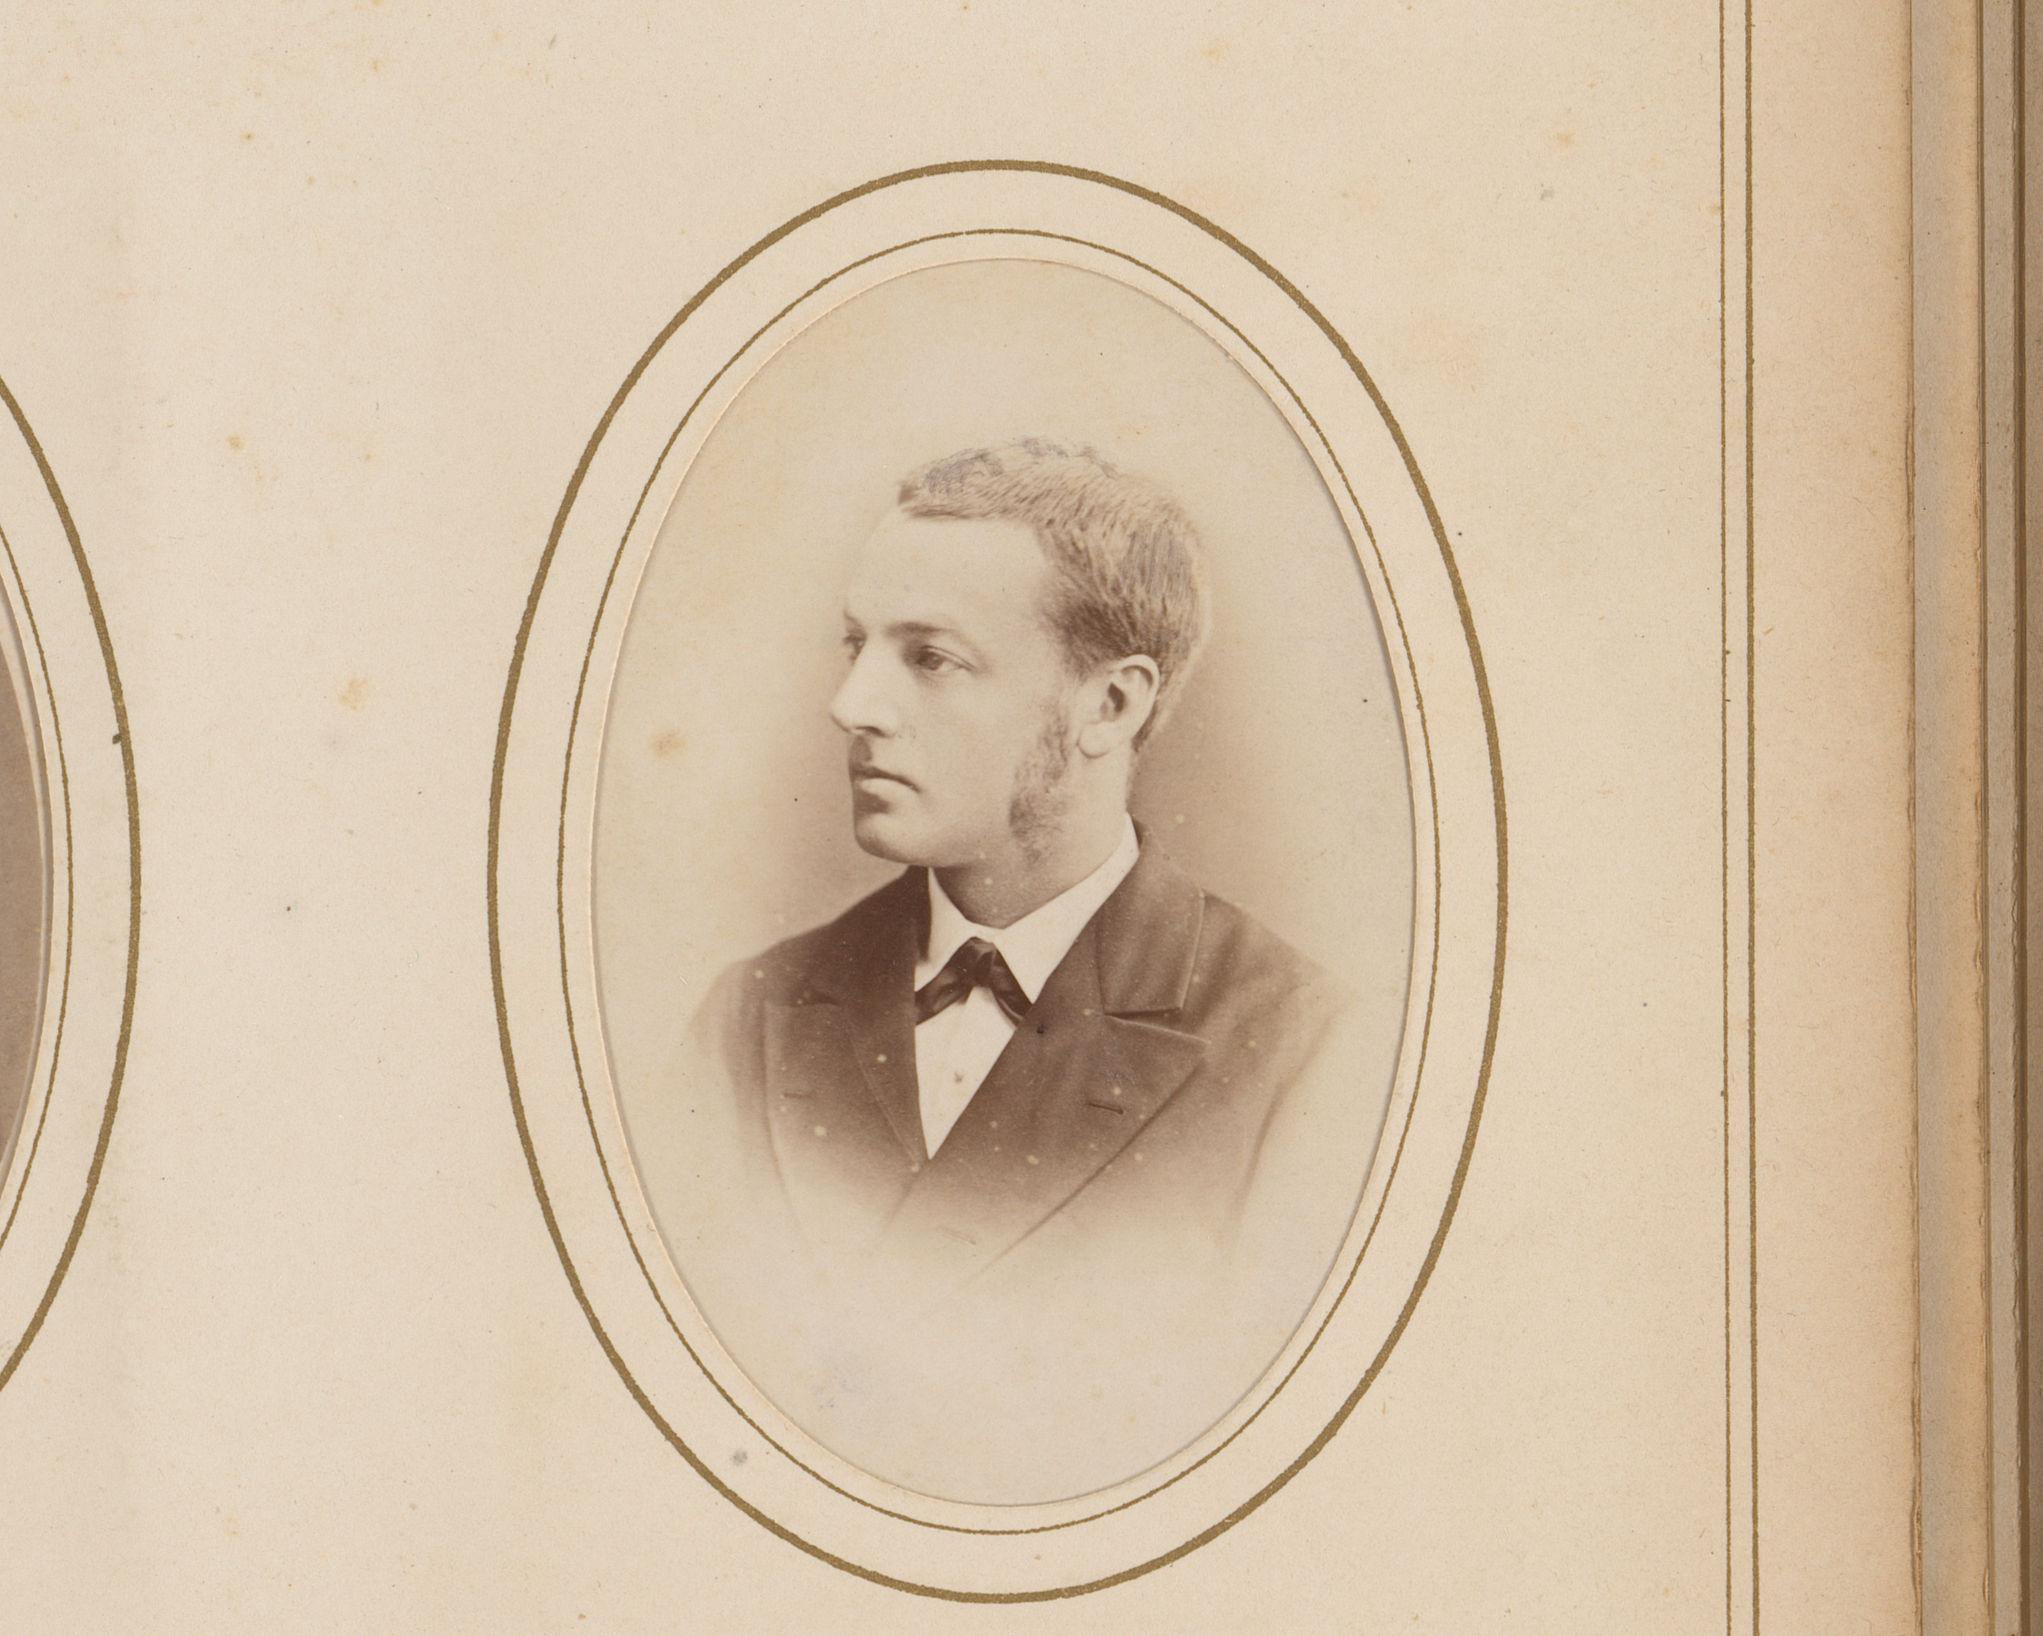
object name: album leaf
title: Portret van een man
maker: max büttinghausen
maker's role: fotograaf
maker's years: 1847-1906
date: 1873-1895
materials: cardboard, photographic support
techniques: albumen print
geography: amsterdam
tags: historical persons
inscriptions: inscription: ‘Photographie/ van/ M. Büttinghausen./ Amsterdam/ Singel over de Bergstraat/ G 133./ Specialiteit van Vergrootingen.’